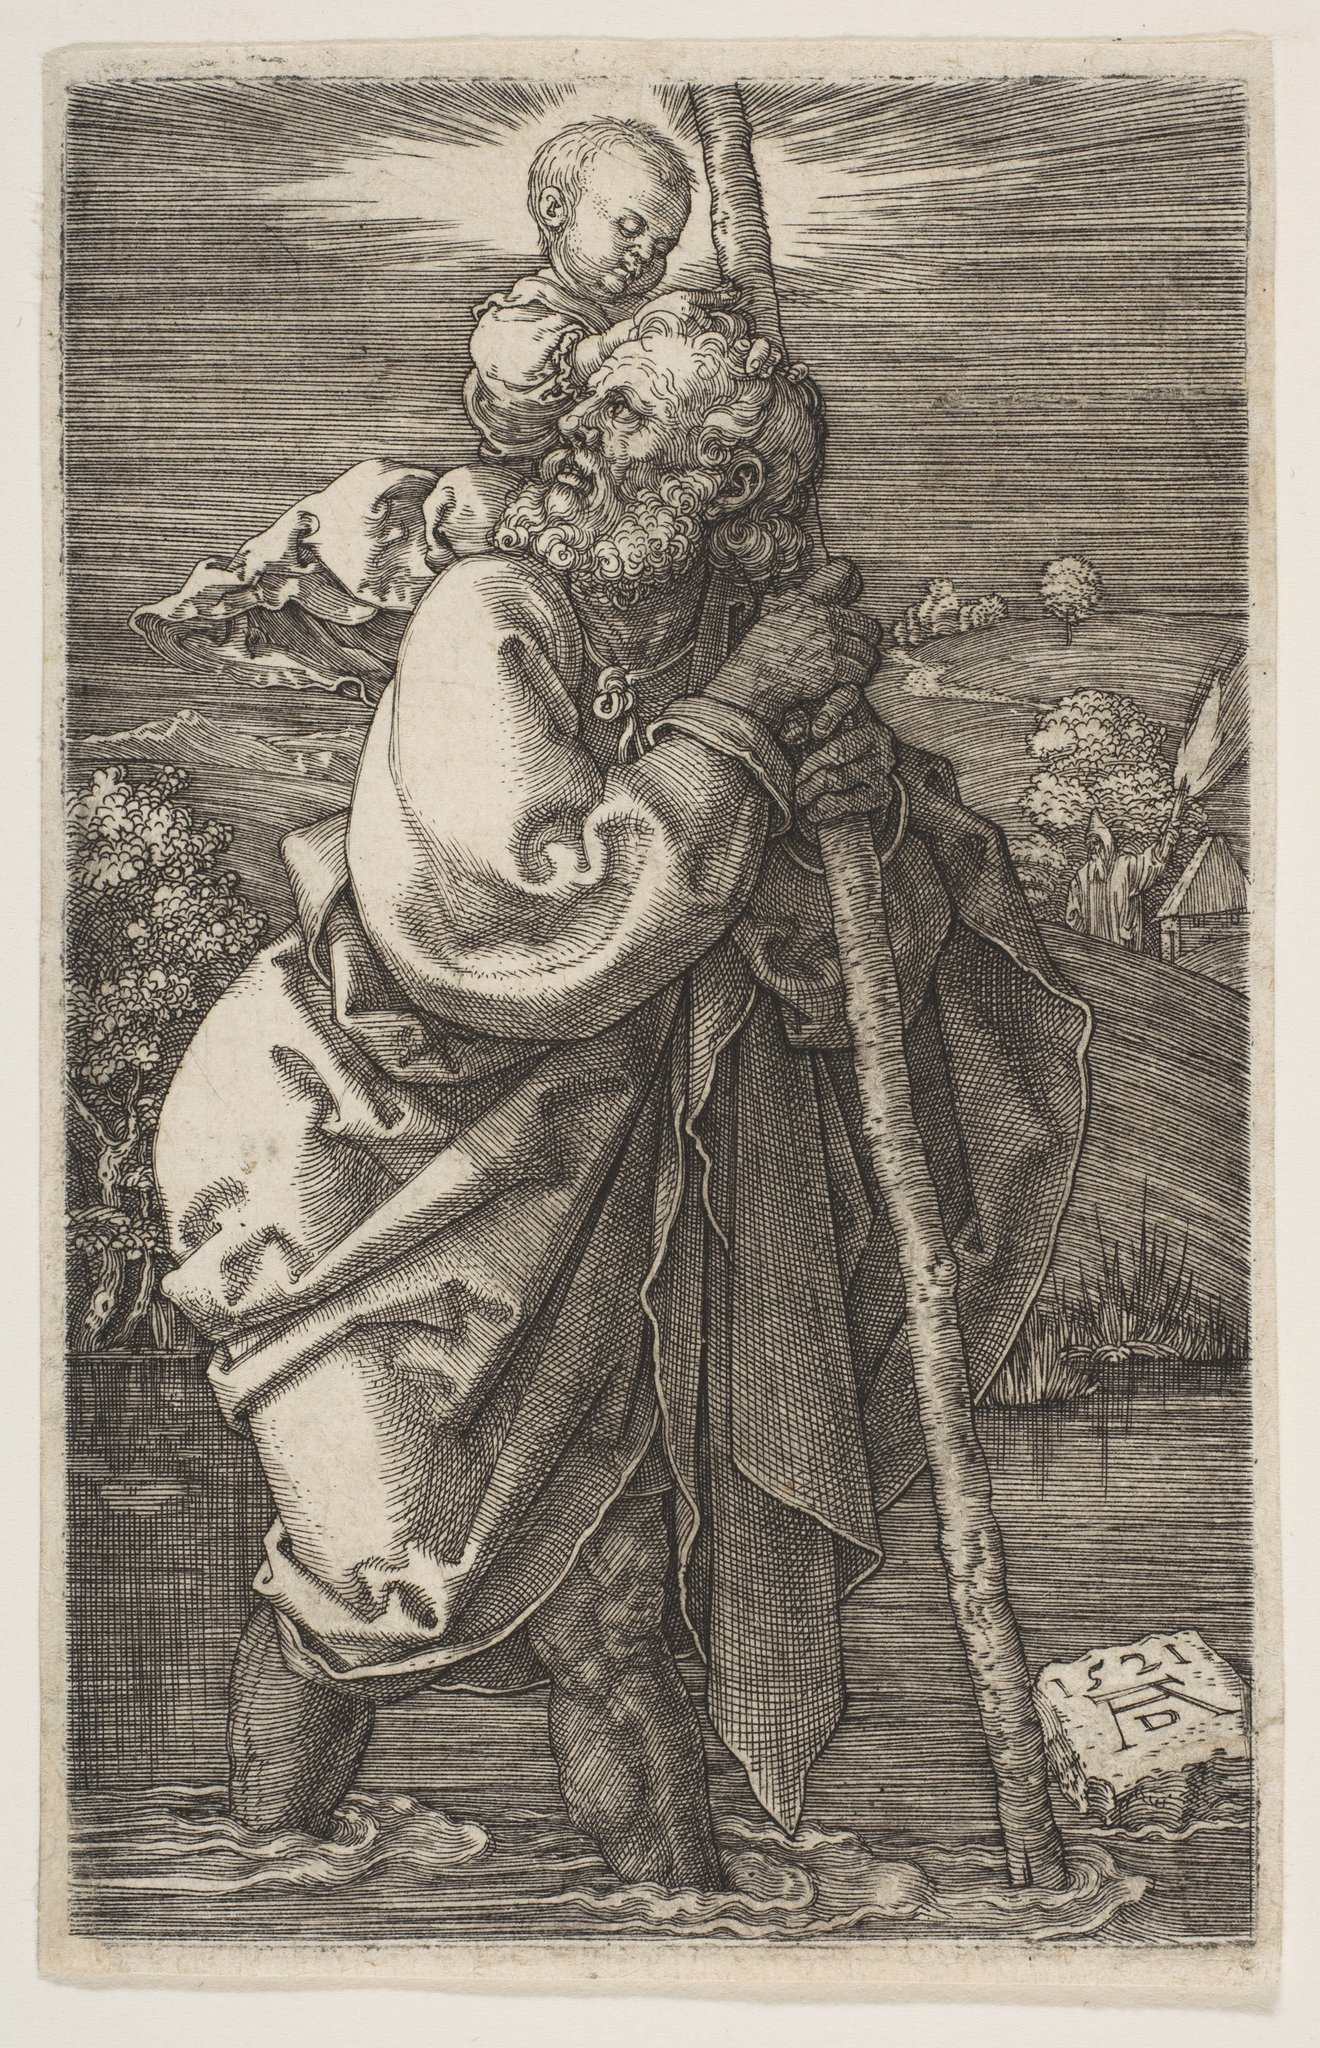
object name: print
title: Saint Christopher Facing Left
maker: albrecht dürer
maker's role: artist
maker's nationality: german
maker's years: 1471-1528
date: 1521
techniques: engraving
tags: christ,saint christopher